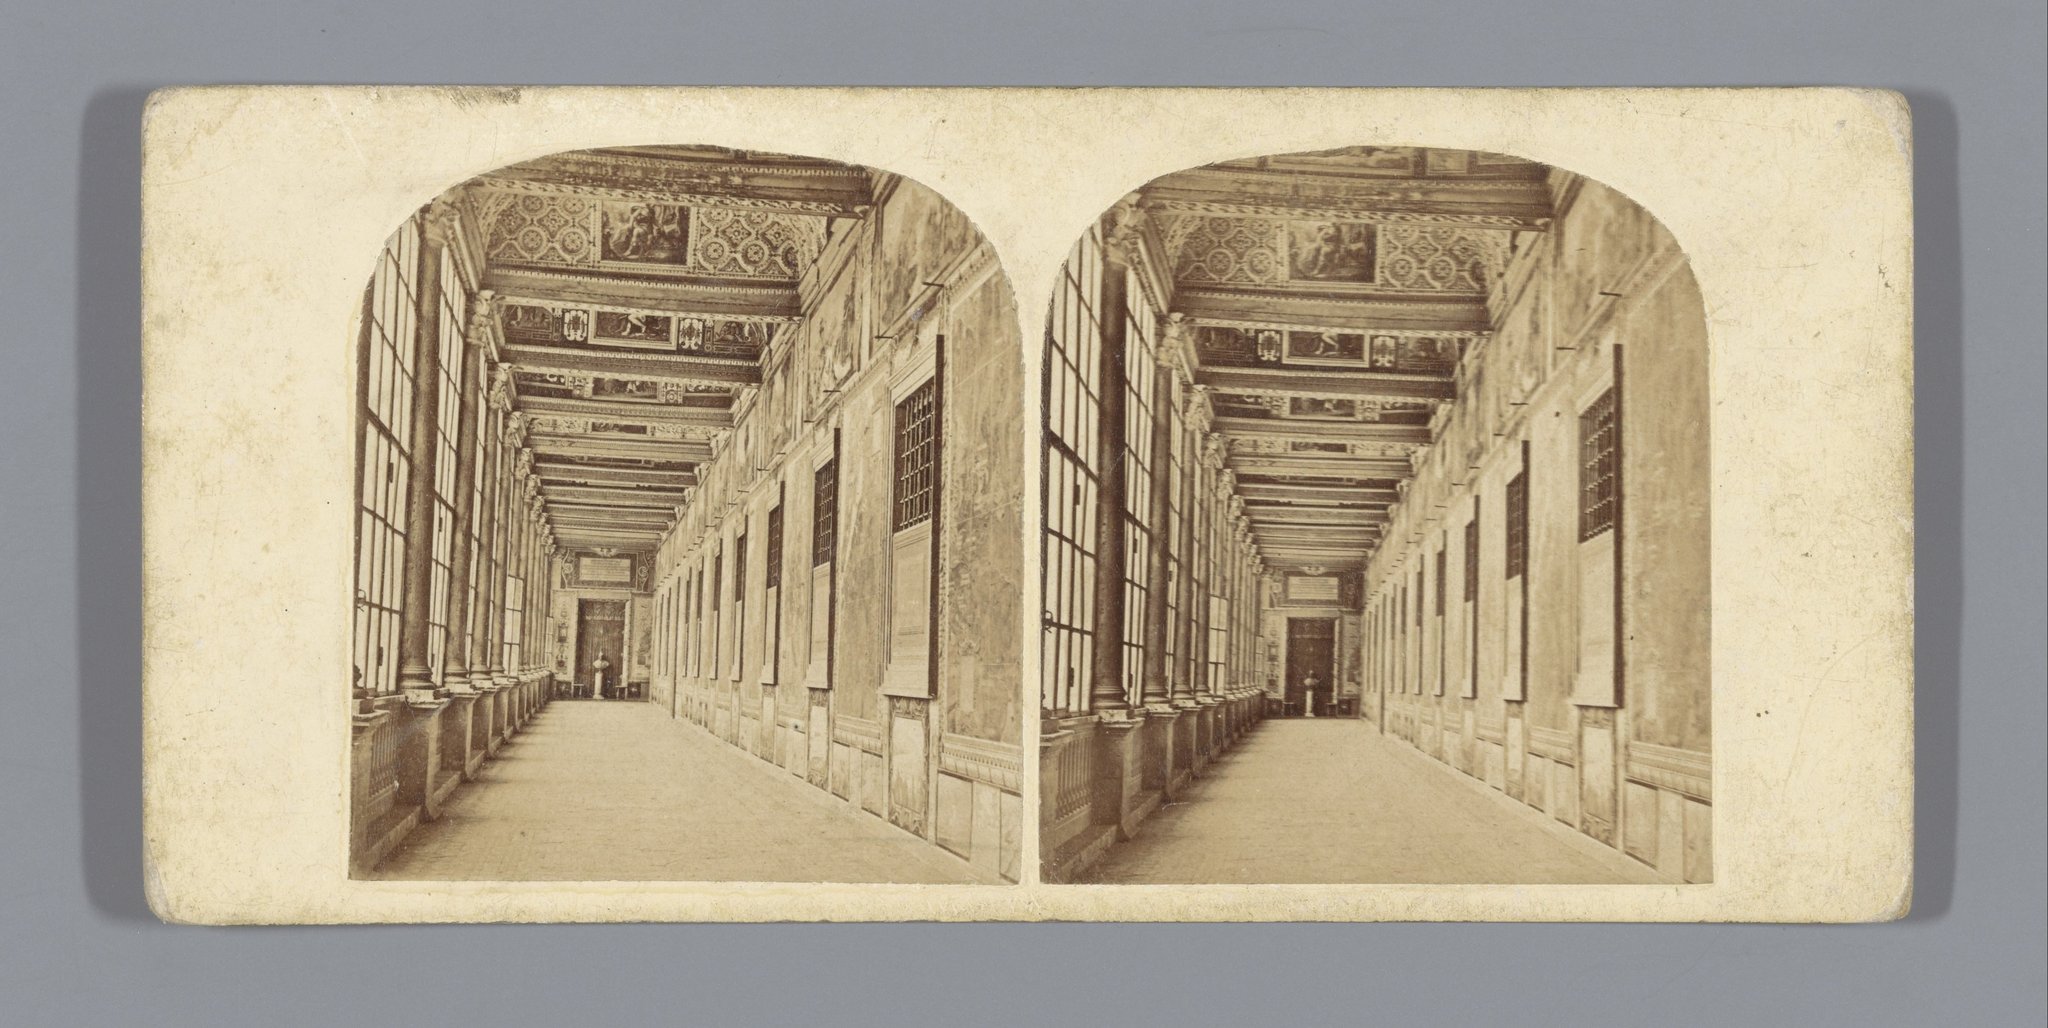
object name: stereograph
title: Corridor te Vaticaanstad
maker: Anonymous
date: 1850-1880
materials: cardboard, photographic support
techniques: albumen print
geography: vatican city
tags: corridor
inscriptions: inscription: ‘Les Loges de Raphael Vatican’